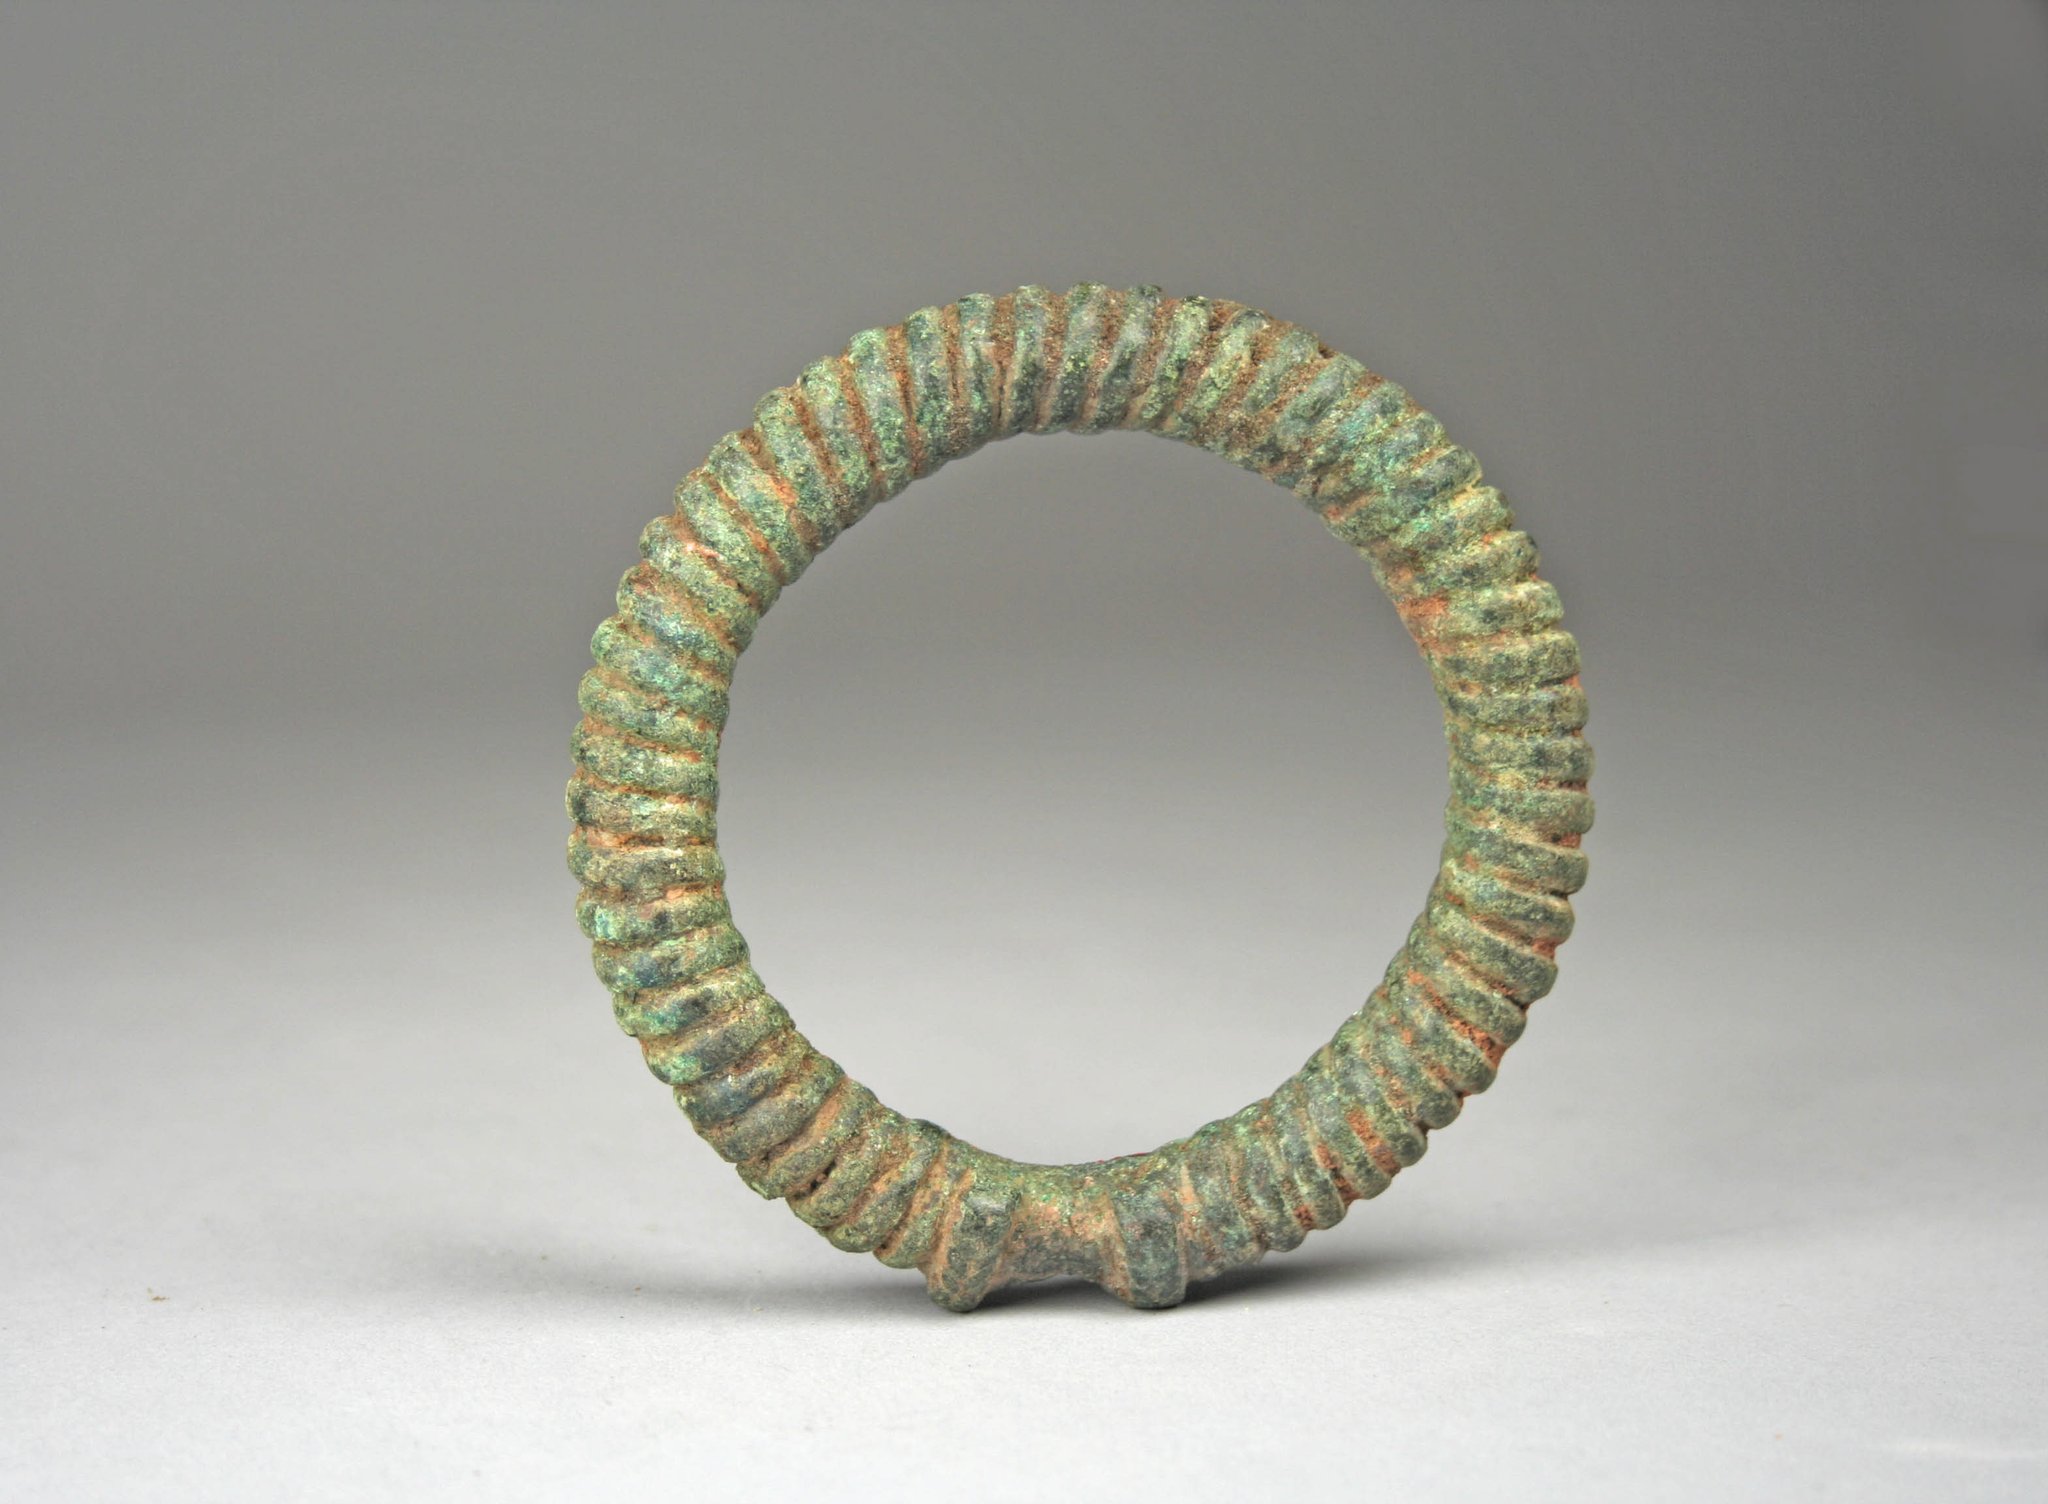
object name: bracelet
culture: middle niger civilization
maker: middle niger artist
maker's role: artist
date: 1301-1400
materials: copper alloy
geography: mali